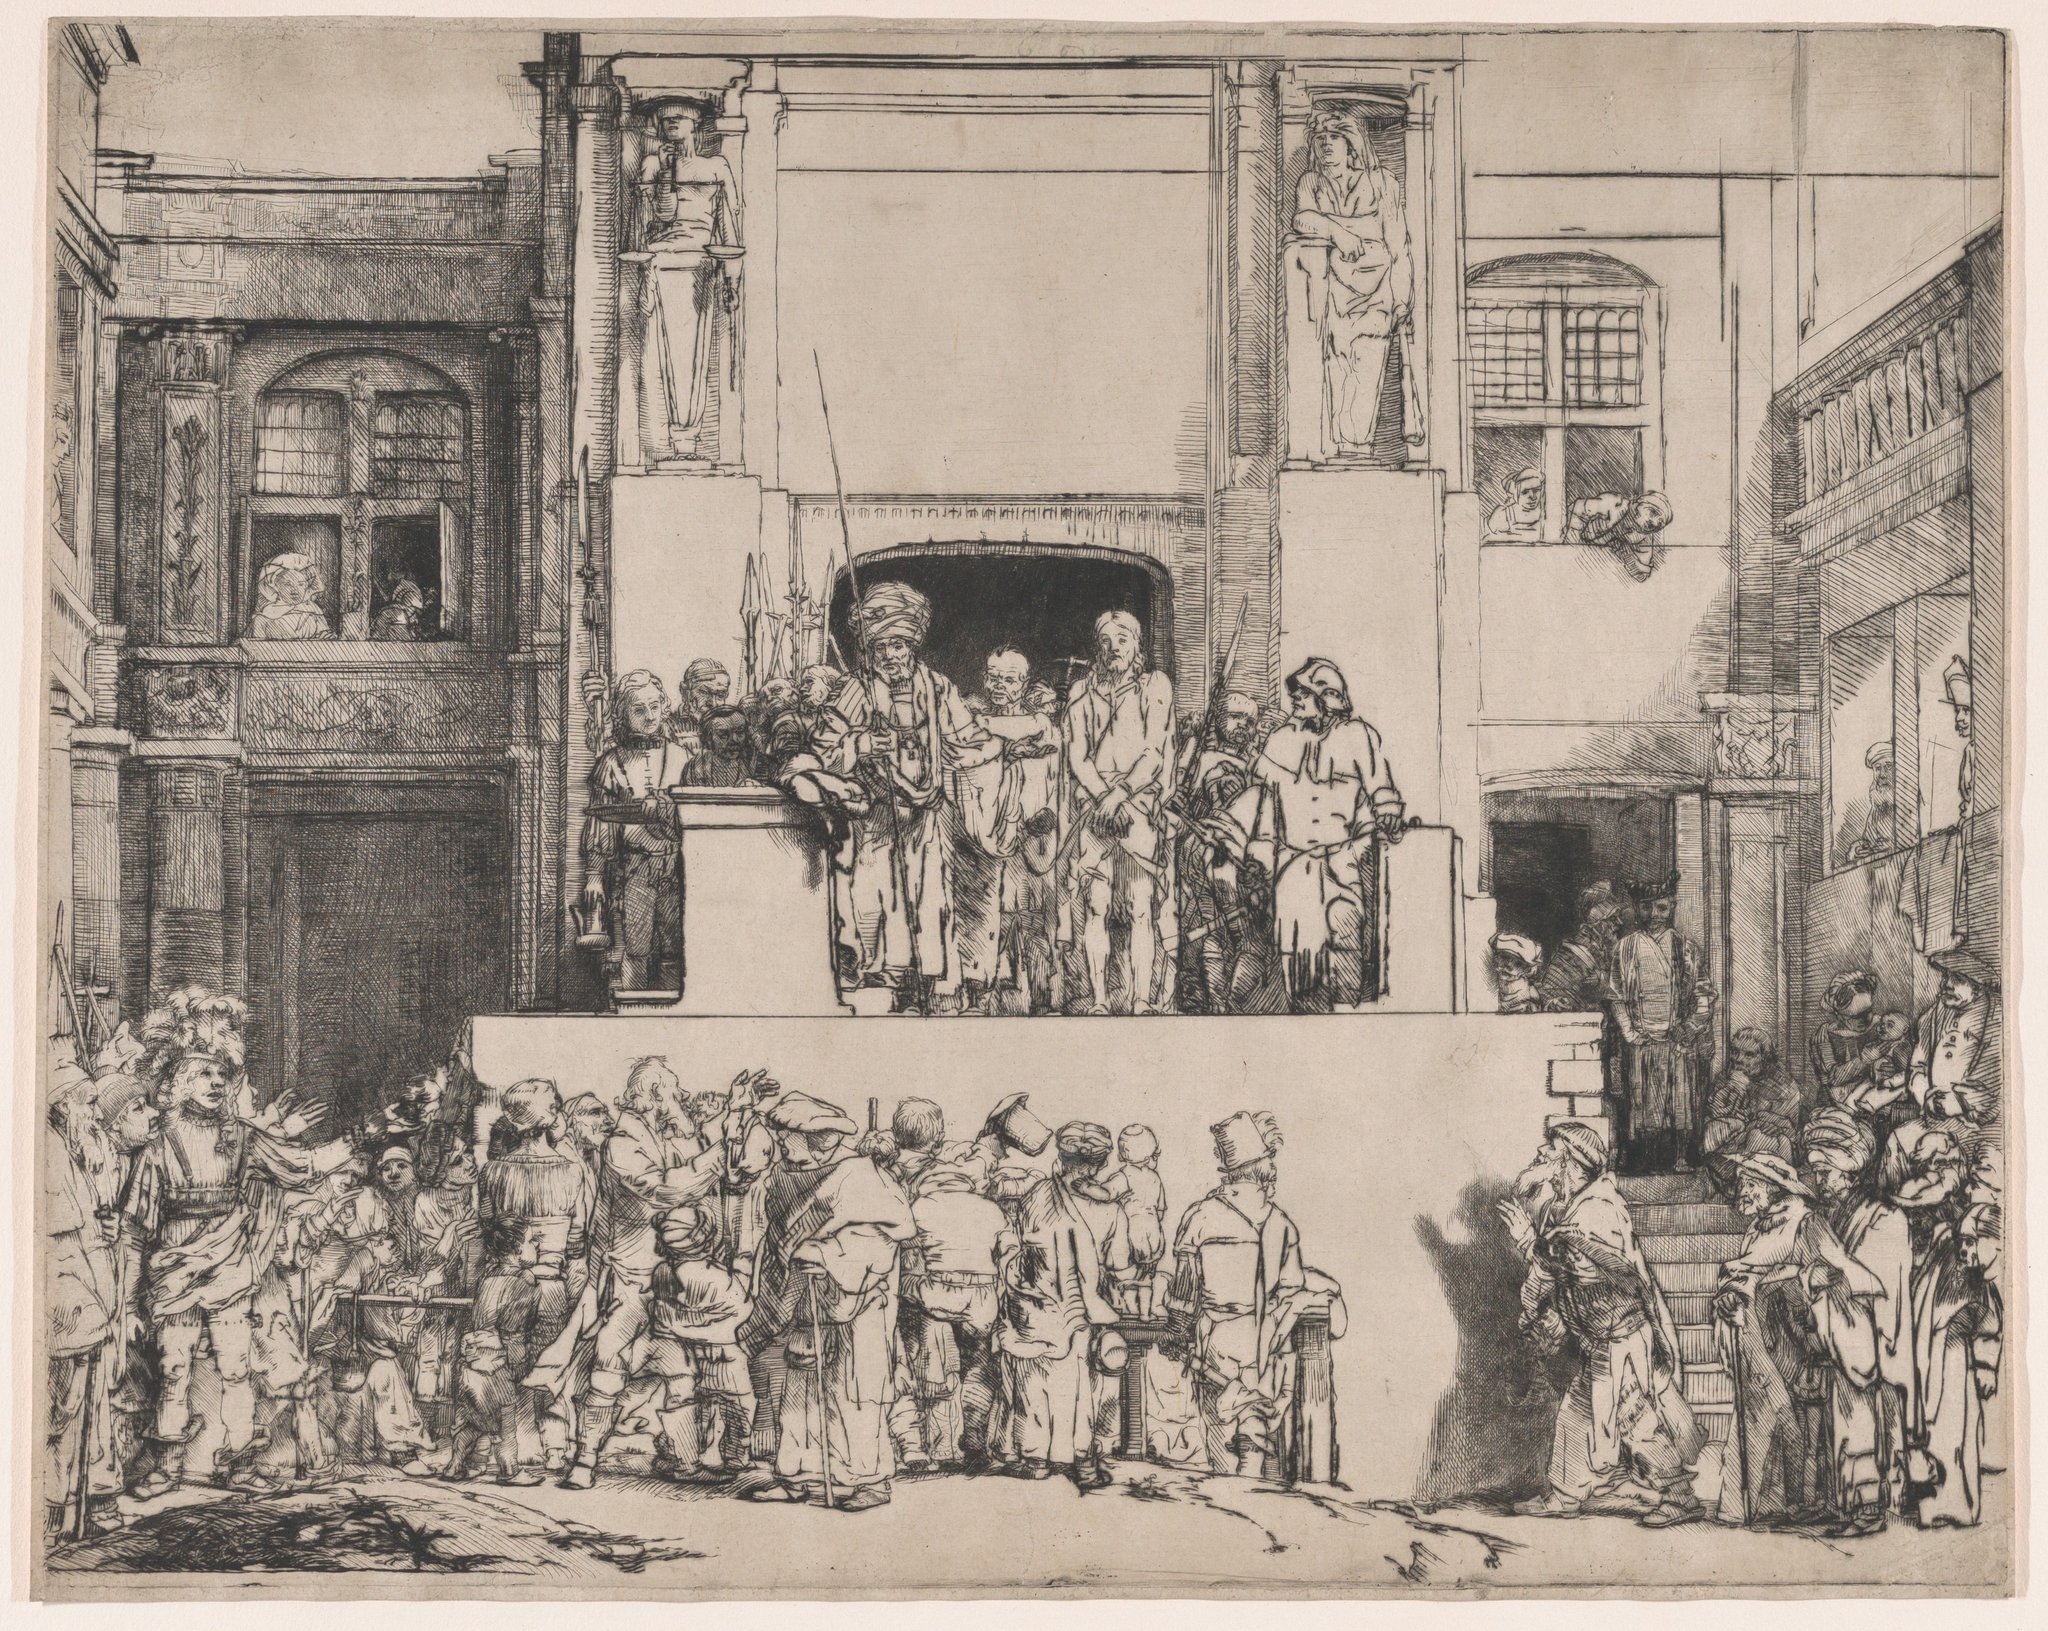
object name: print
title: Christ Presented to the People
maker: rembrandt van rijn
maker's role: artist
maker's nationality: dutch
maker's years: 1606-1669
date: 1655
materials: paper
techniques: drypoint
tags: men,christ,crowd